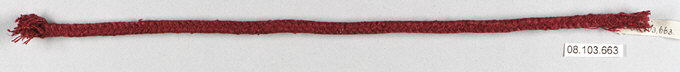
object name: cord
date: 1701-1900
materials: silk